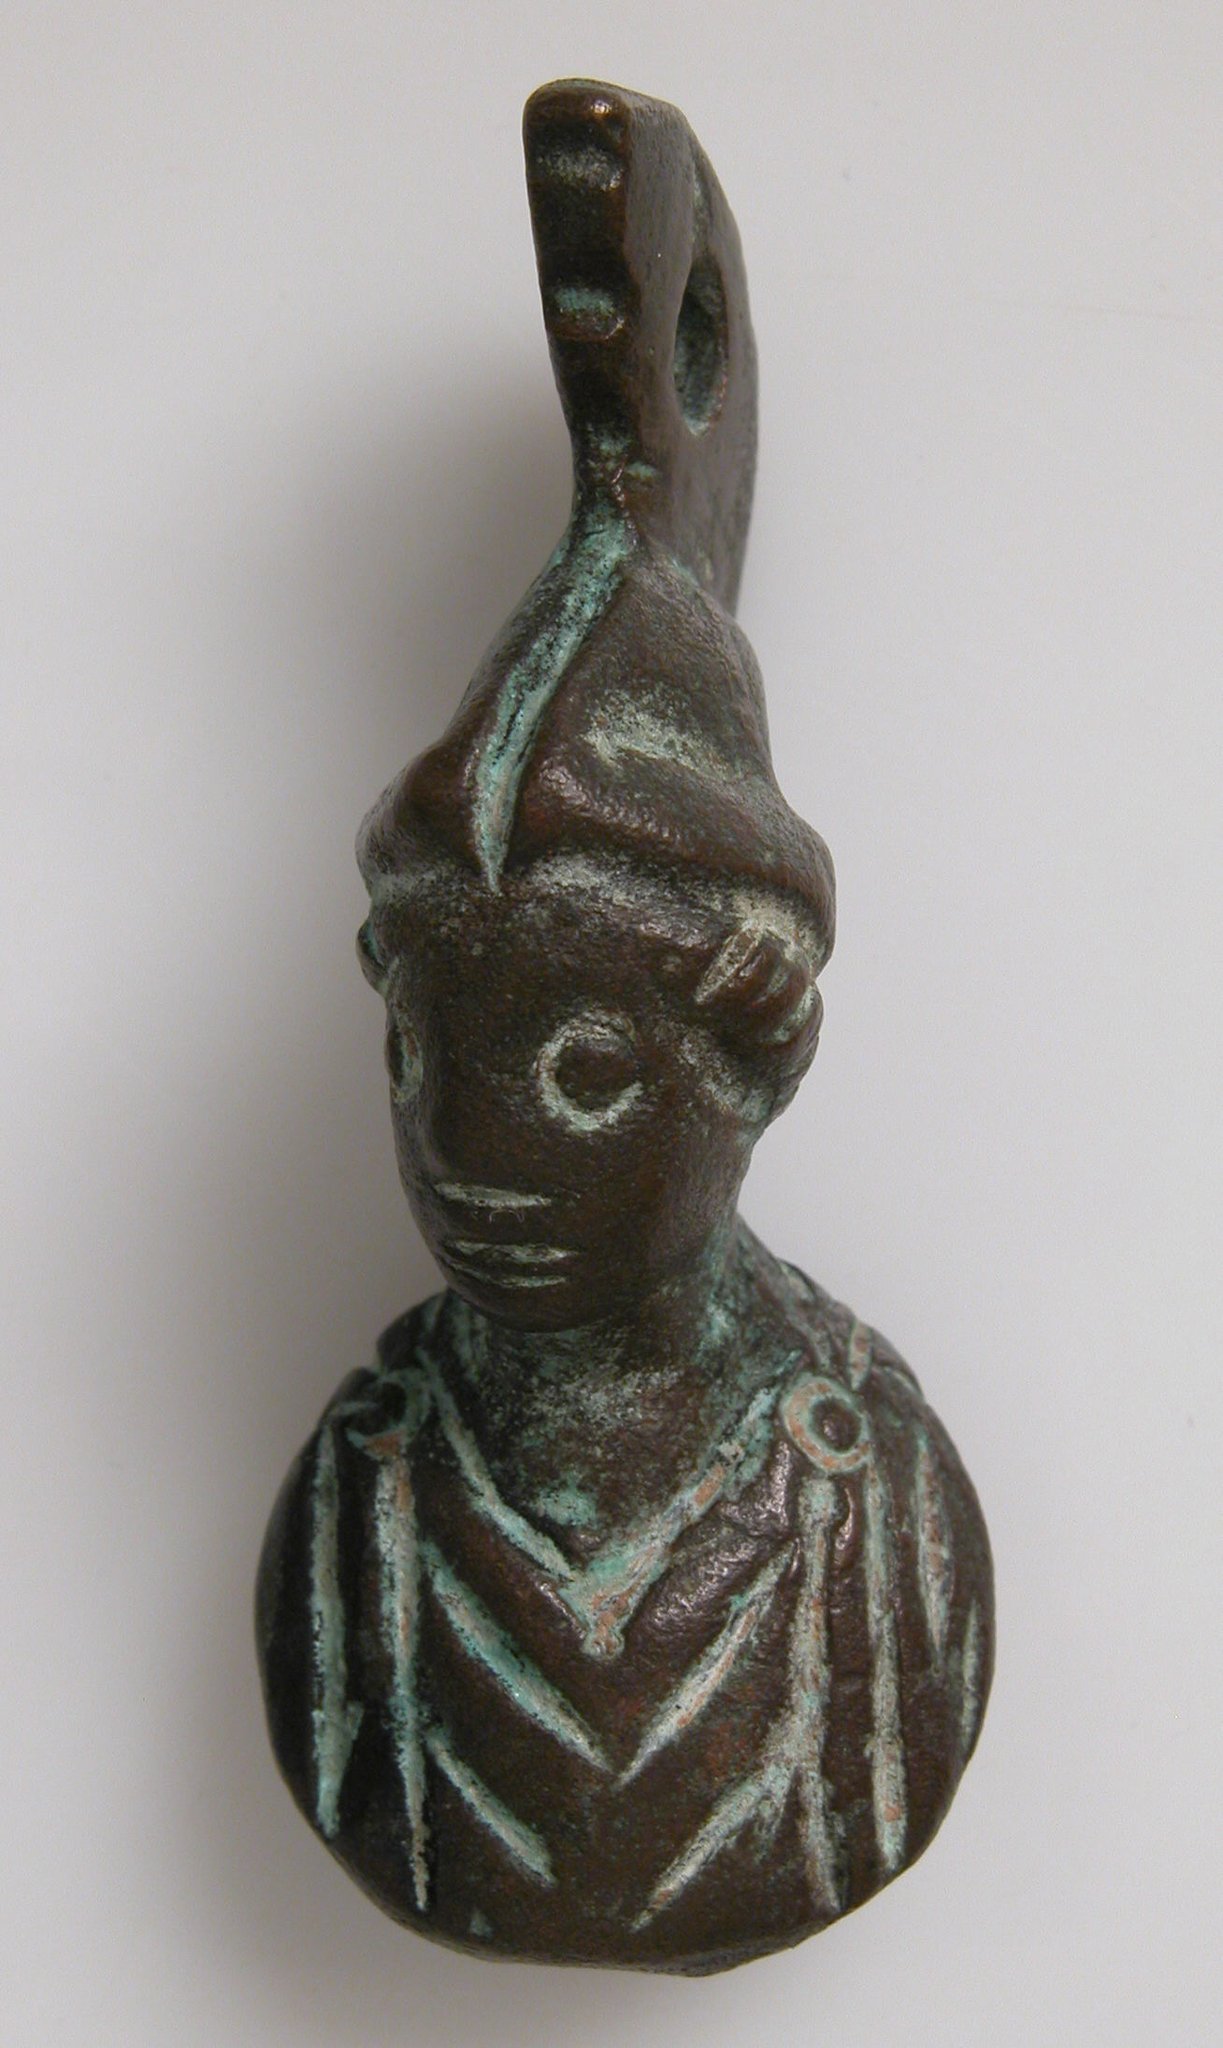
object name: steelyard weight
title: Steelyard Weight with the Bust of Athena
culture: byzantine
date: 401-700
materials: copper alloy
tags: athena